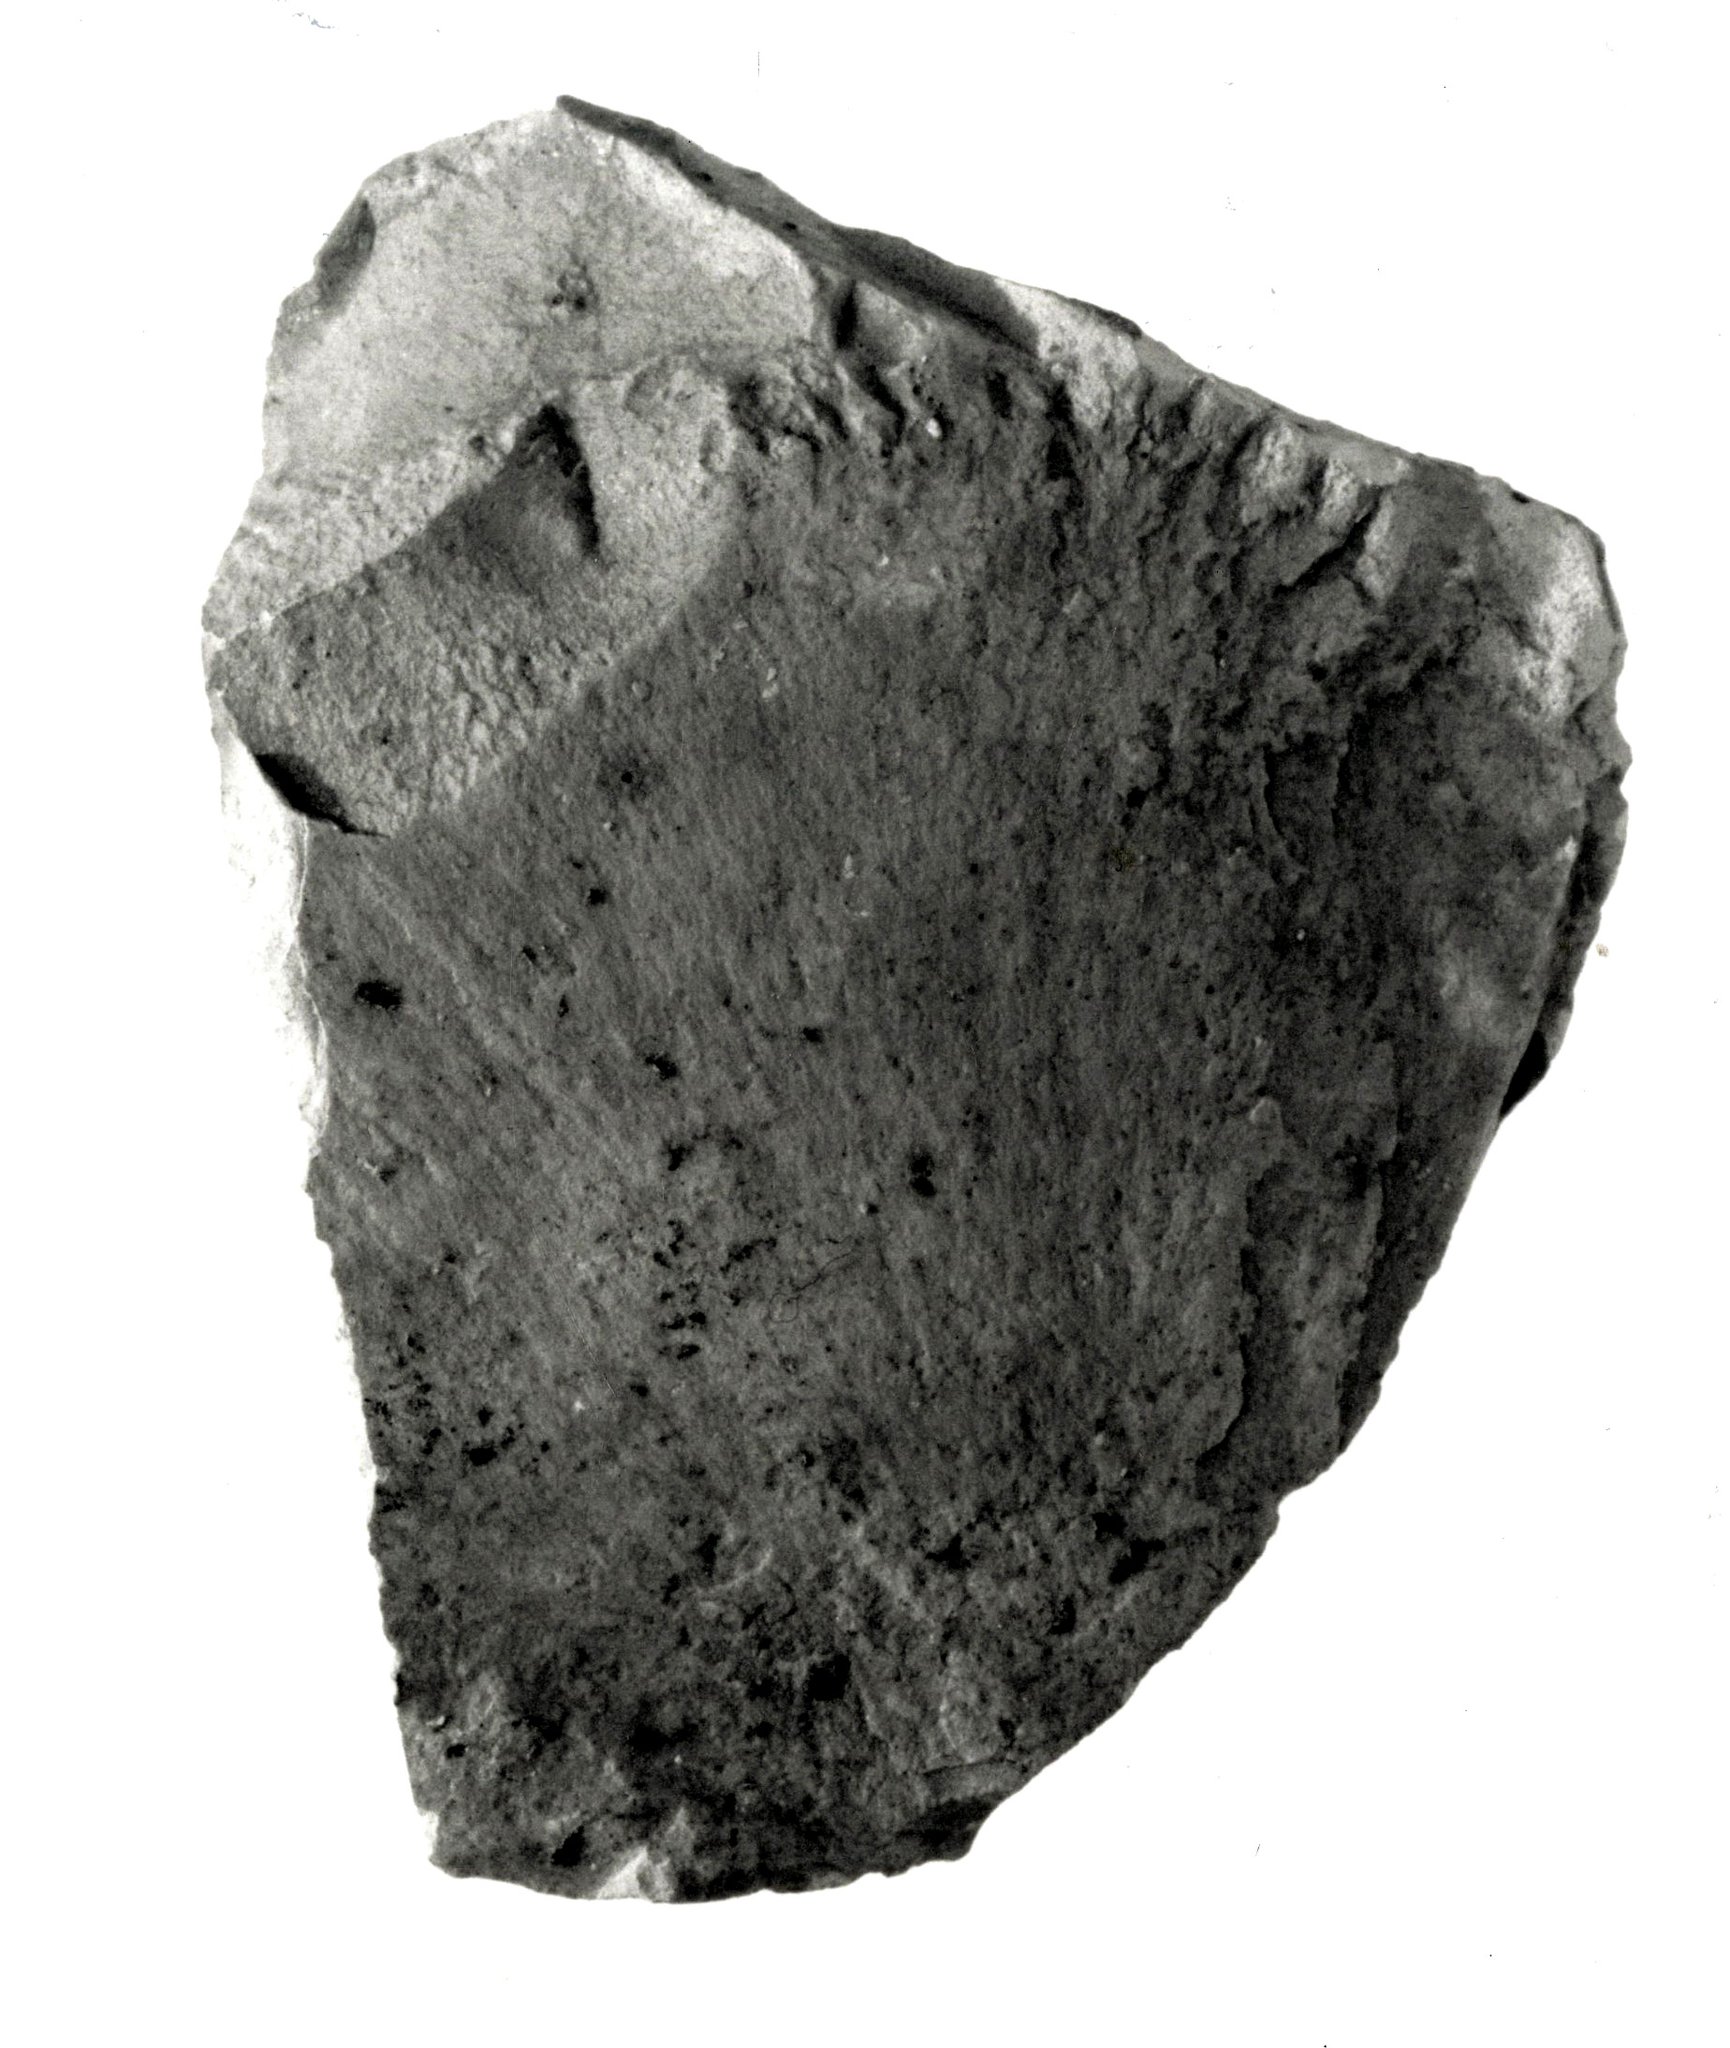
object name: relief, tomb of nespekashuty, wall casing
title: Wall casing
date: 664-610 BCE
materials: limestone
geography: egypt